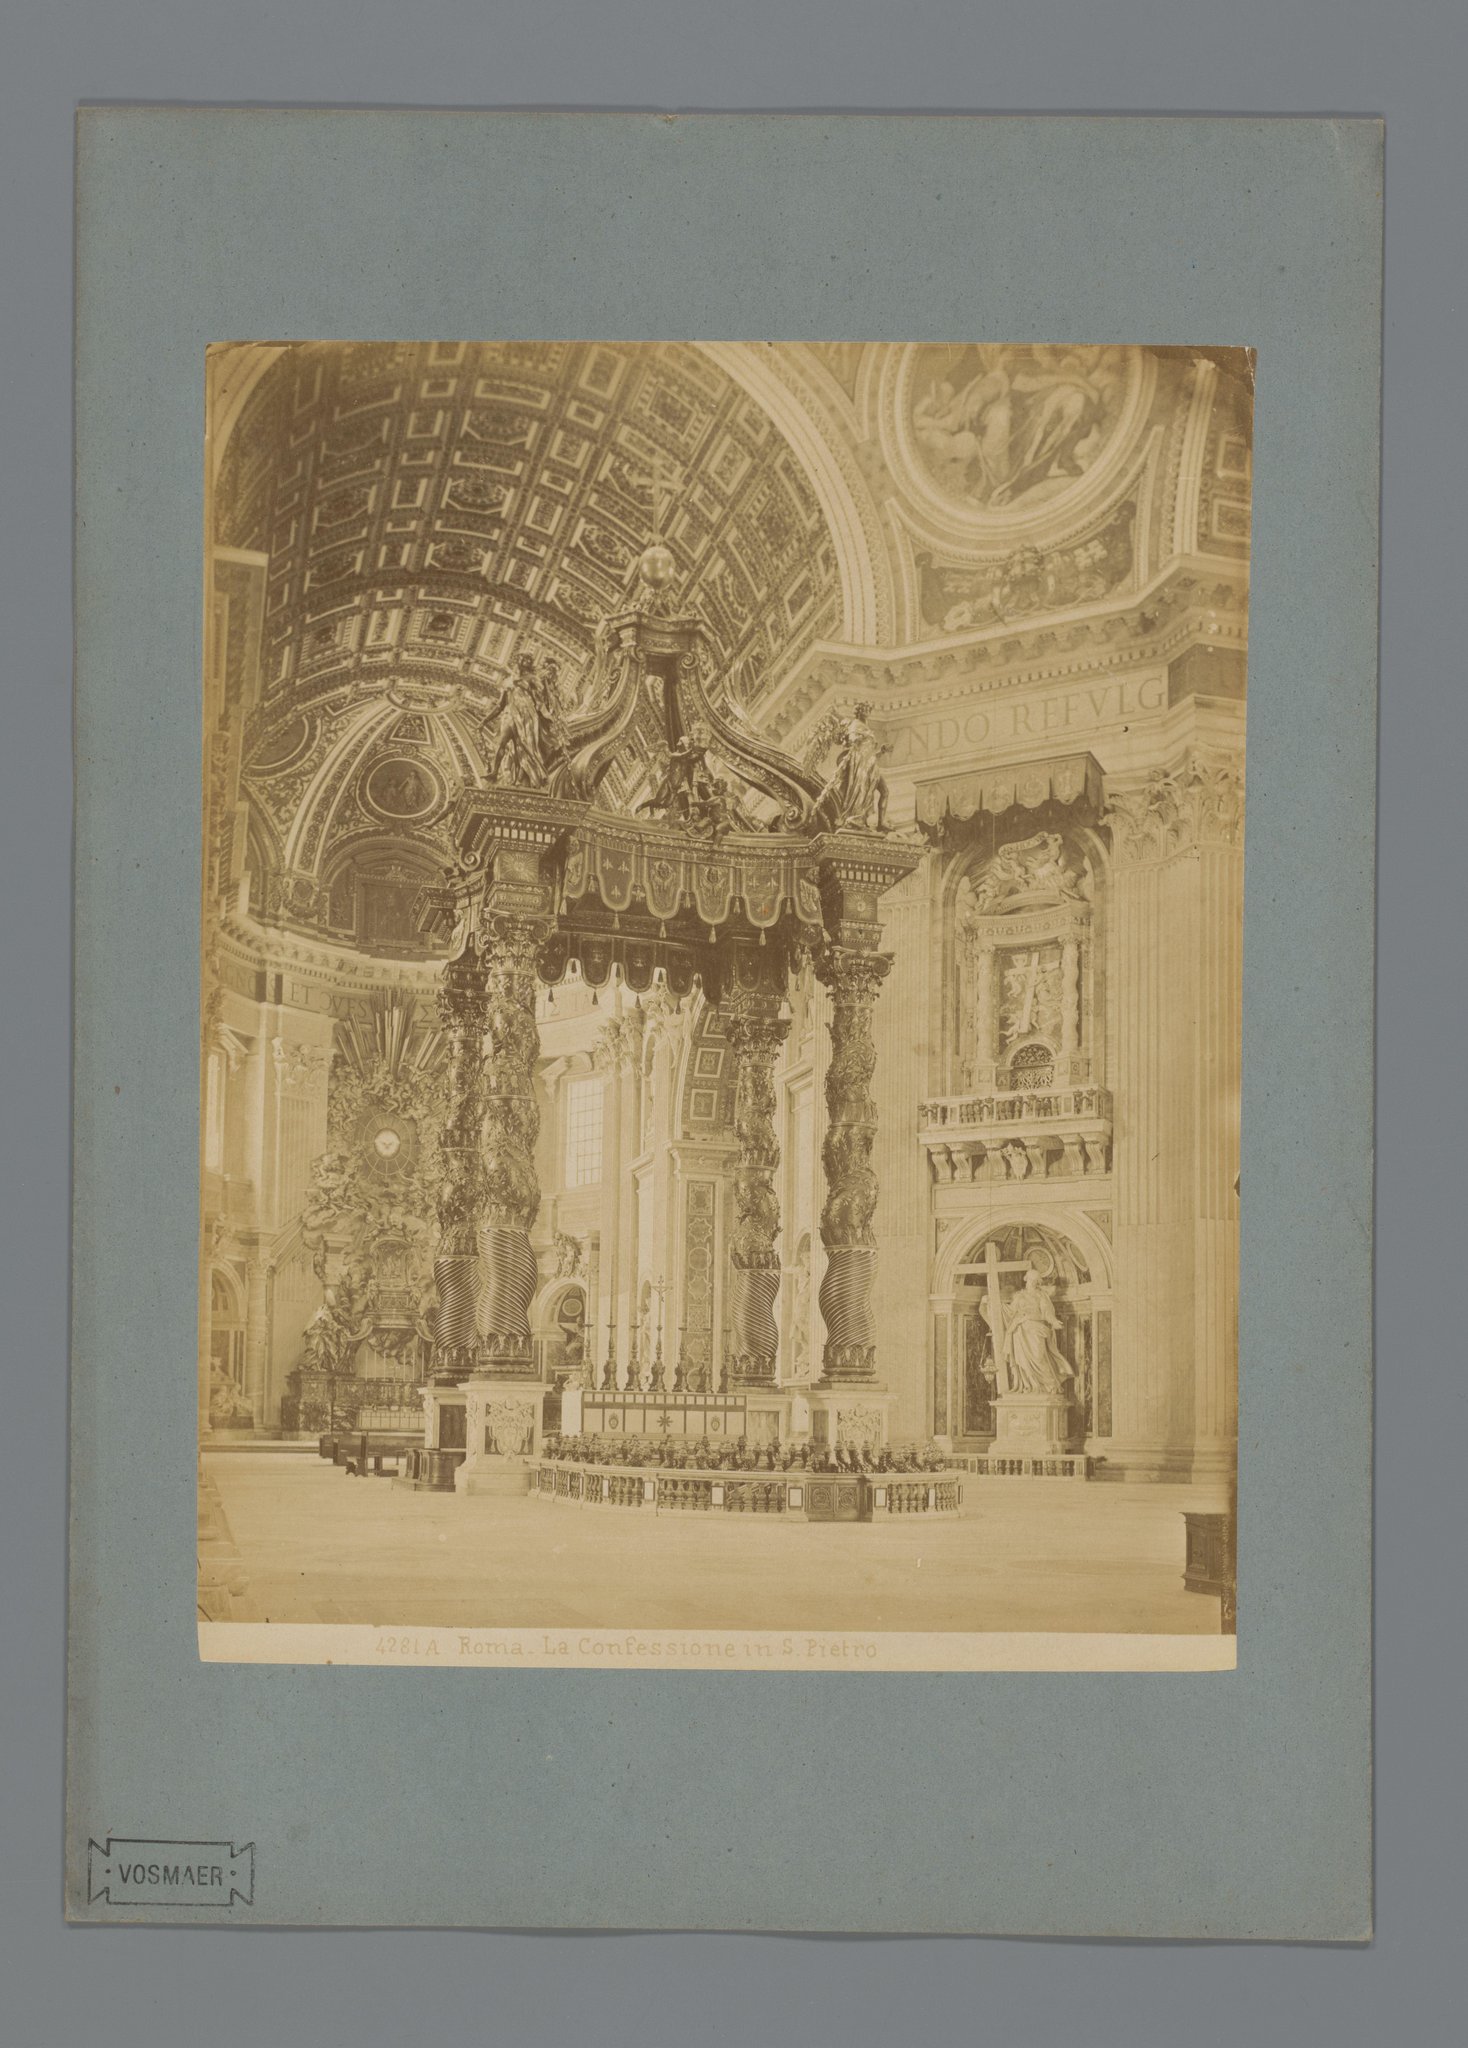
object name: photograph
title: Baldakijn in de Sint-Pietersbasiliek te Rome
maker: Anonymous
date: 1851-1900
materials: cardboard, paper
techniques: albumen print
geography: sint-pietersbasiliek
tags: canopy, baldachin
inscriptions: number: ‘4281 A.’, collector's mark: ‘VOSMAER’